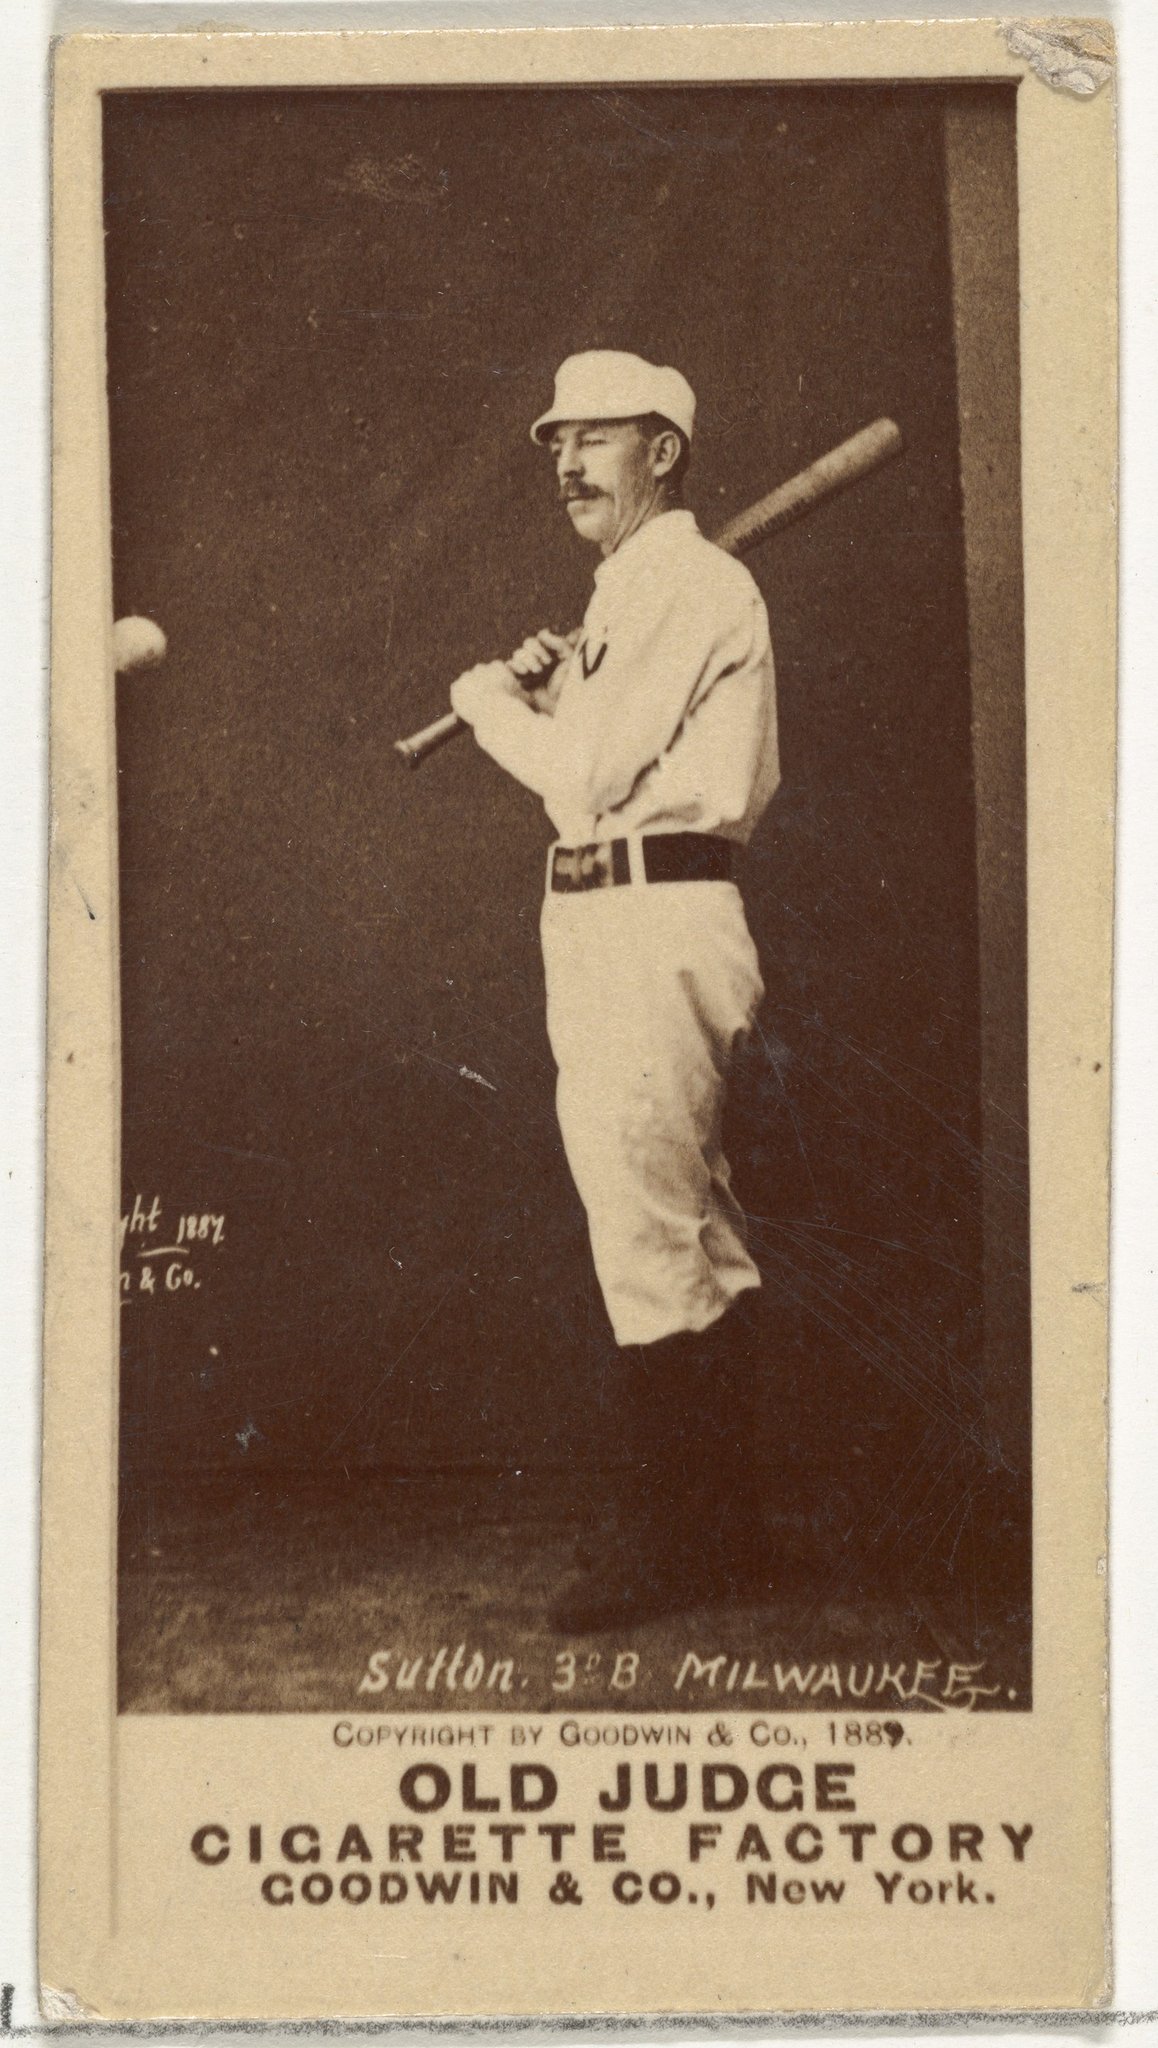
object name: baseball card, photograph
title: Ezra Ballou Sutton, 3rd Base, Milwaukee, from the Old Judge series (N172) for Old Judge Cigarettes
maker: goodwin & company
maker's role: publisher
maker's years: 1850-1950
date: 1887-1889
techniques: albumen silver print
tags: men,portraits,baseball,athletes